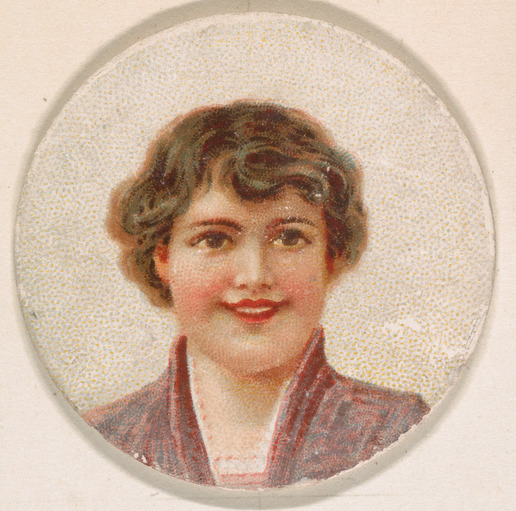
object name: print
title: Portrait of woman, from the Novelties series (N228, Type 1) issued by Kinney Bros.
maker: kinney brothers tobacco company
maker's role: publisher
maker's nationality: american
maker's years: 1869-2011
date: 1889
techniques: color lithograph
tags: portraits,women